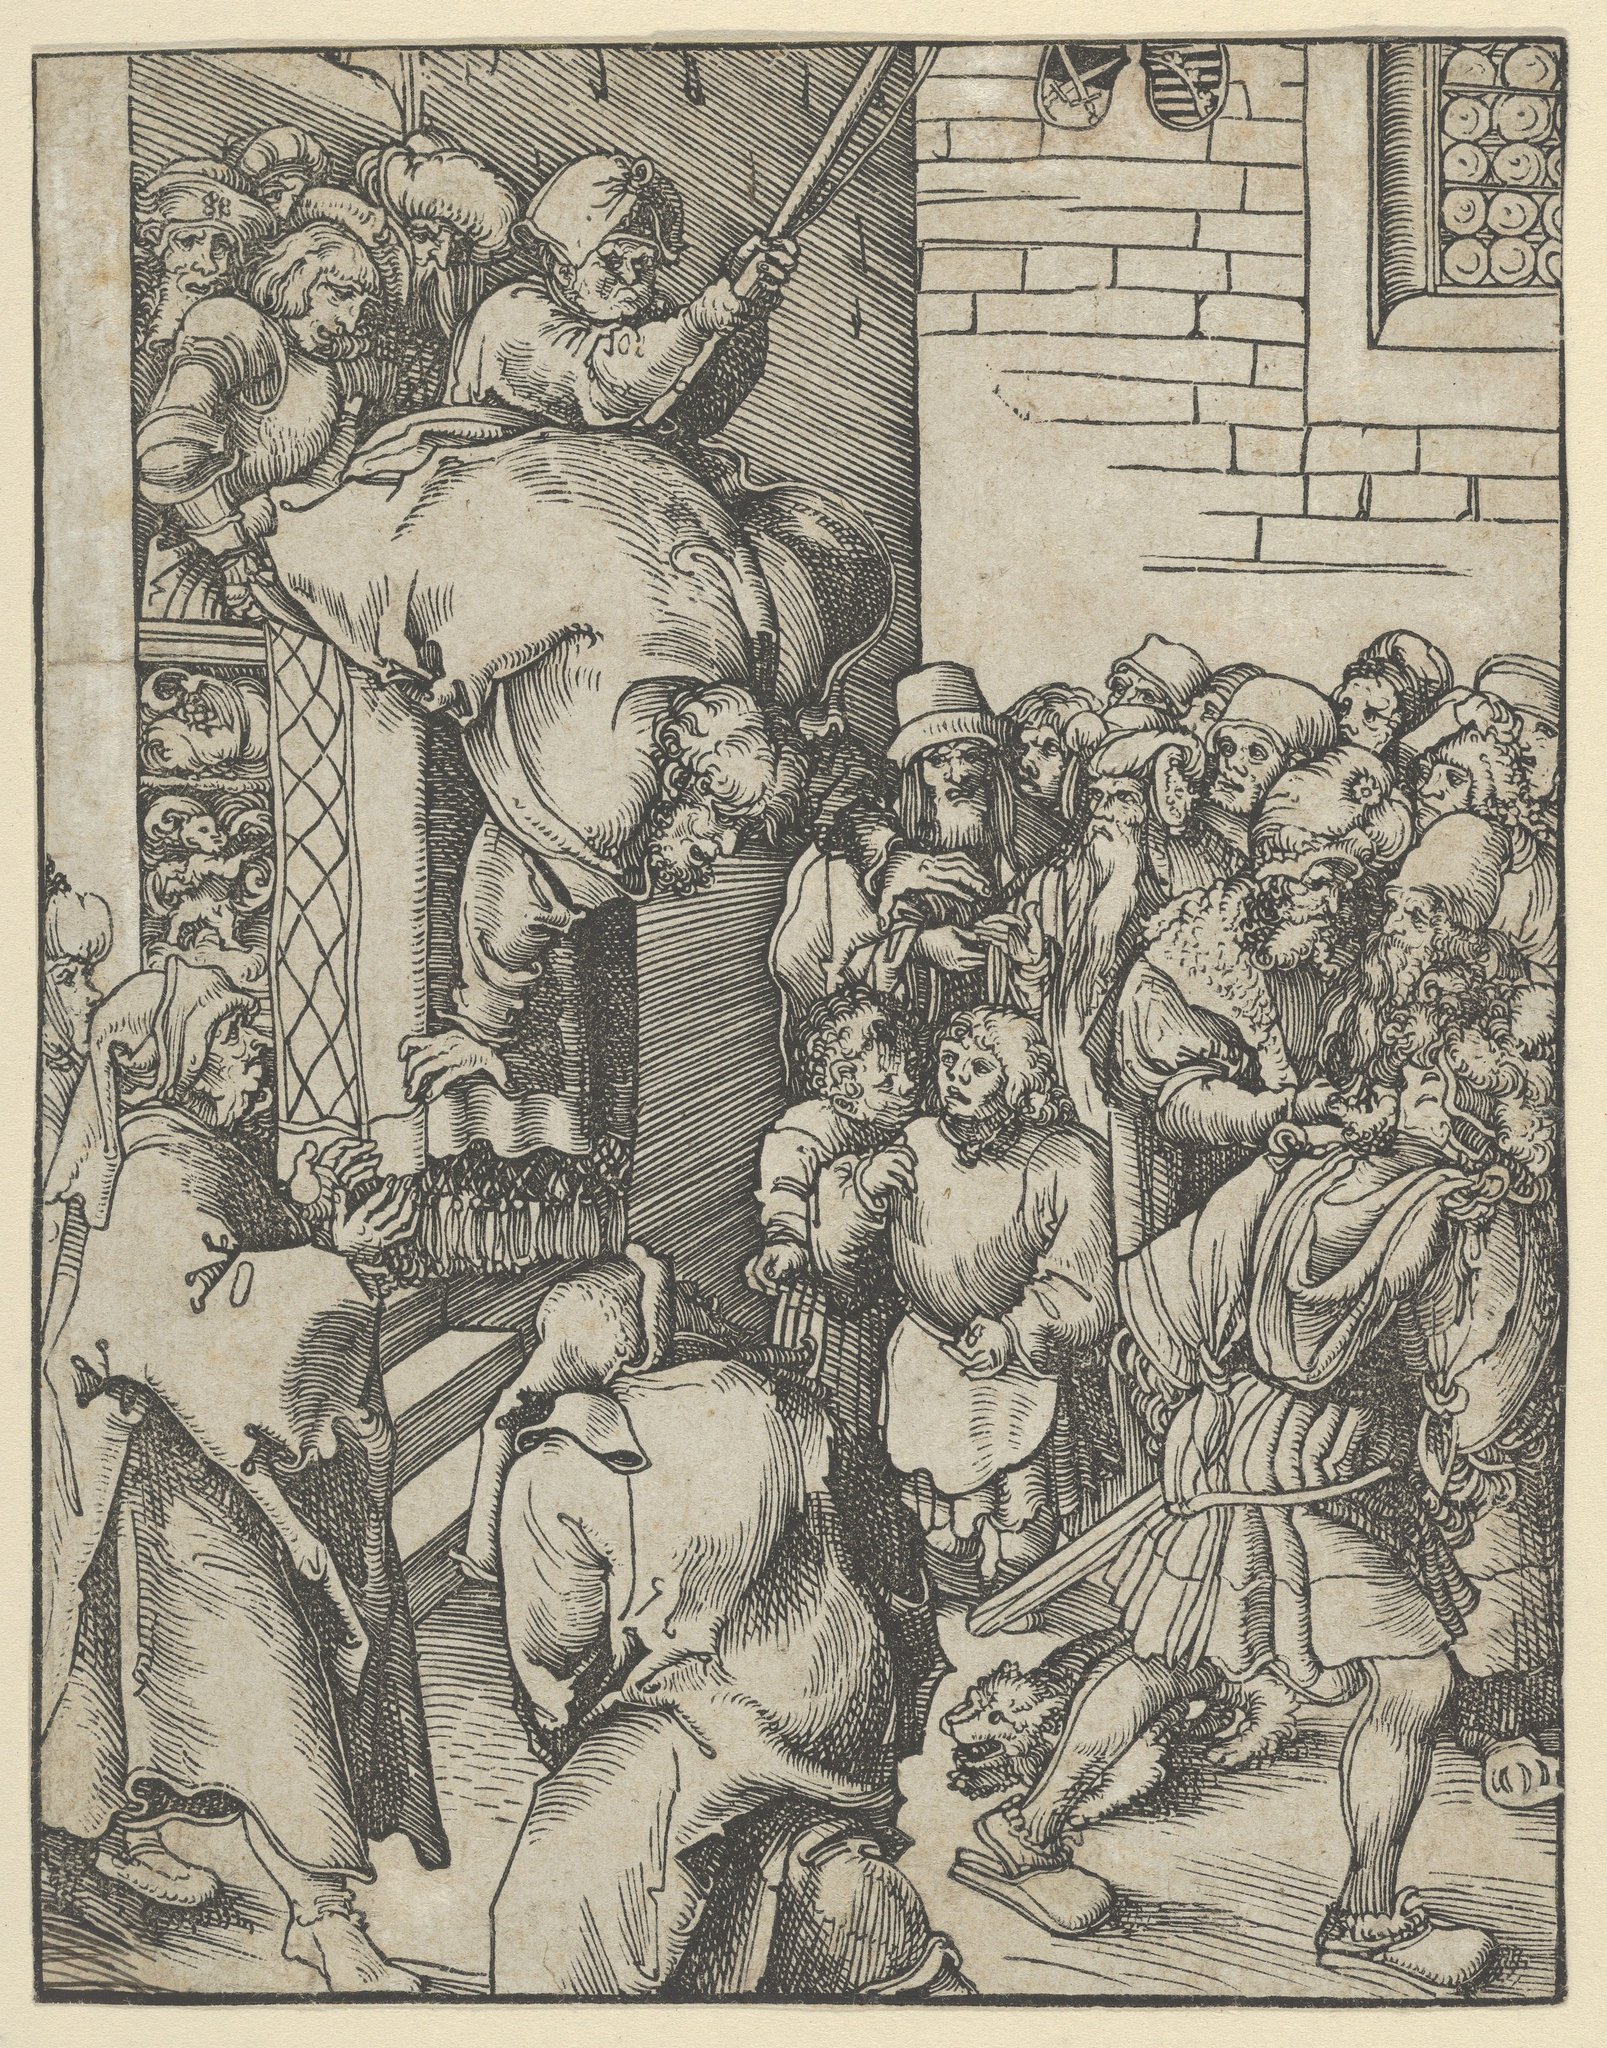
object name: print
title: James The Less from the Martyrdom of the Twelve Apostles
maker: lucas cranach the elder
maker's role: artist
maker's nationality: german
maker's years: 1472-1553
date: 1472-1553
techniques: woodcut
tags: suffering,men,apostles